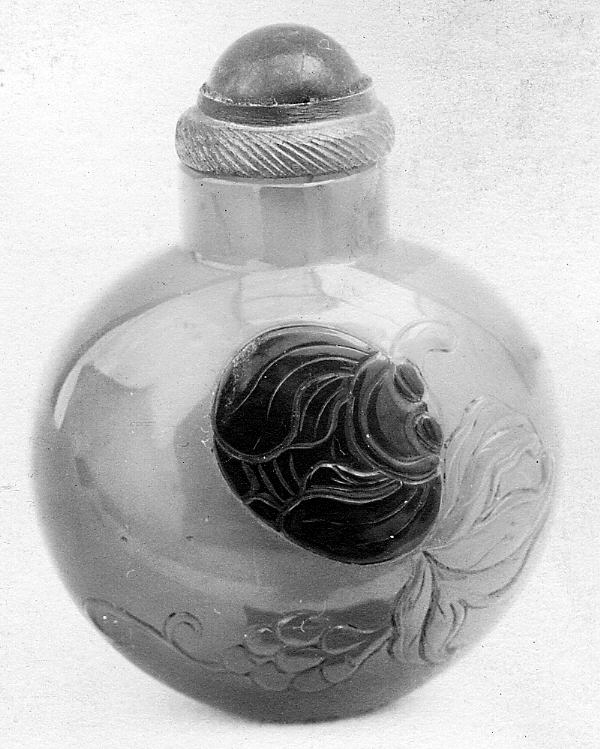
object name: snuff bottle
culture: chinese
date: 1736-1795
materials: stone